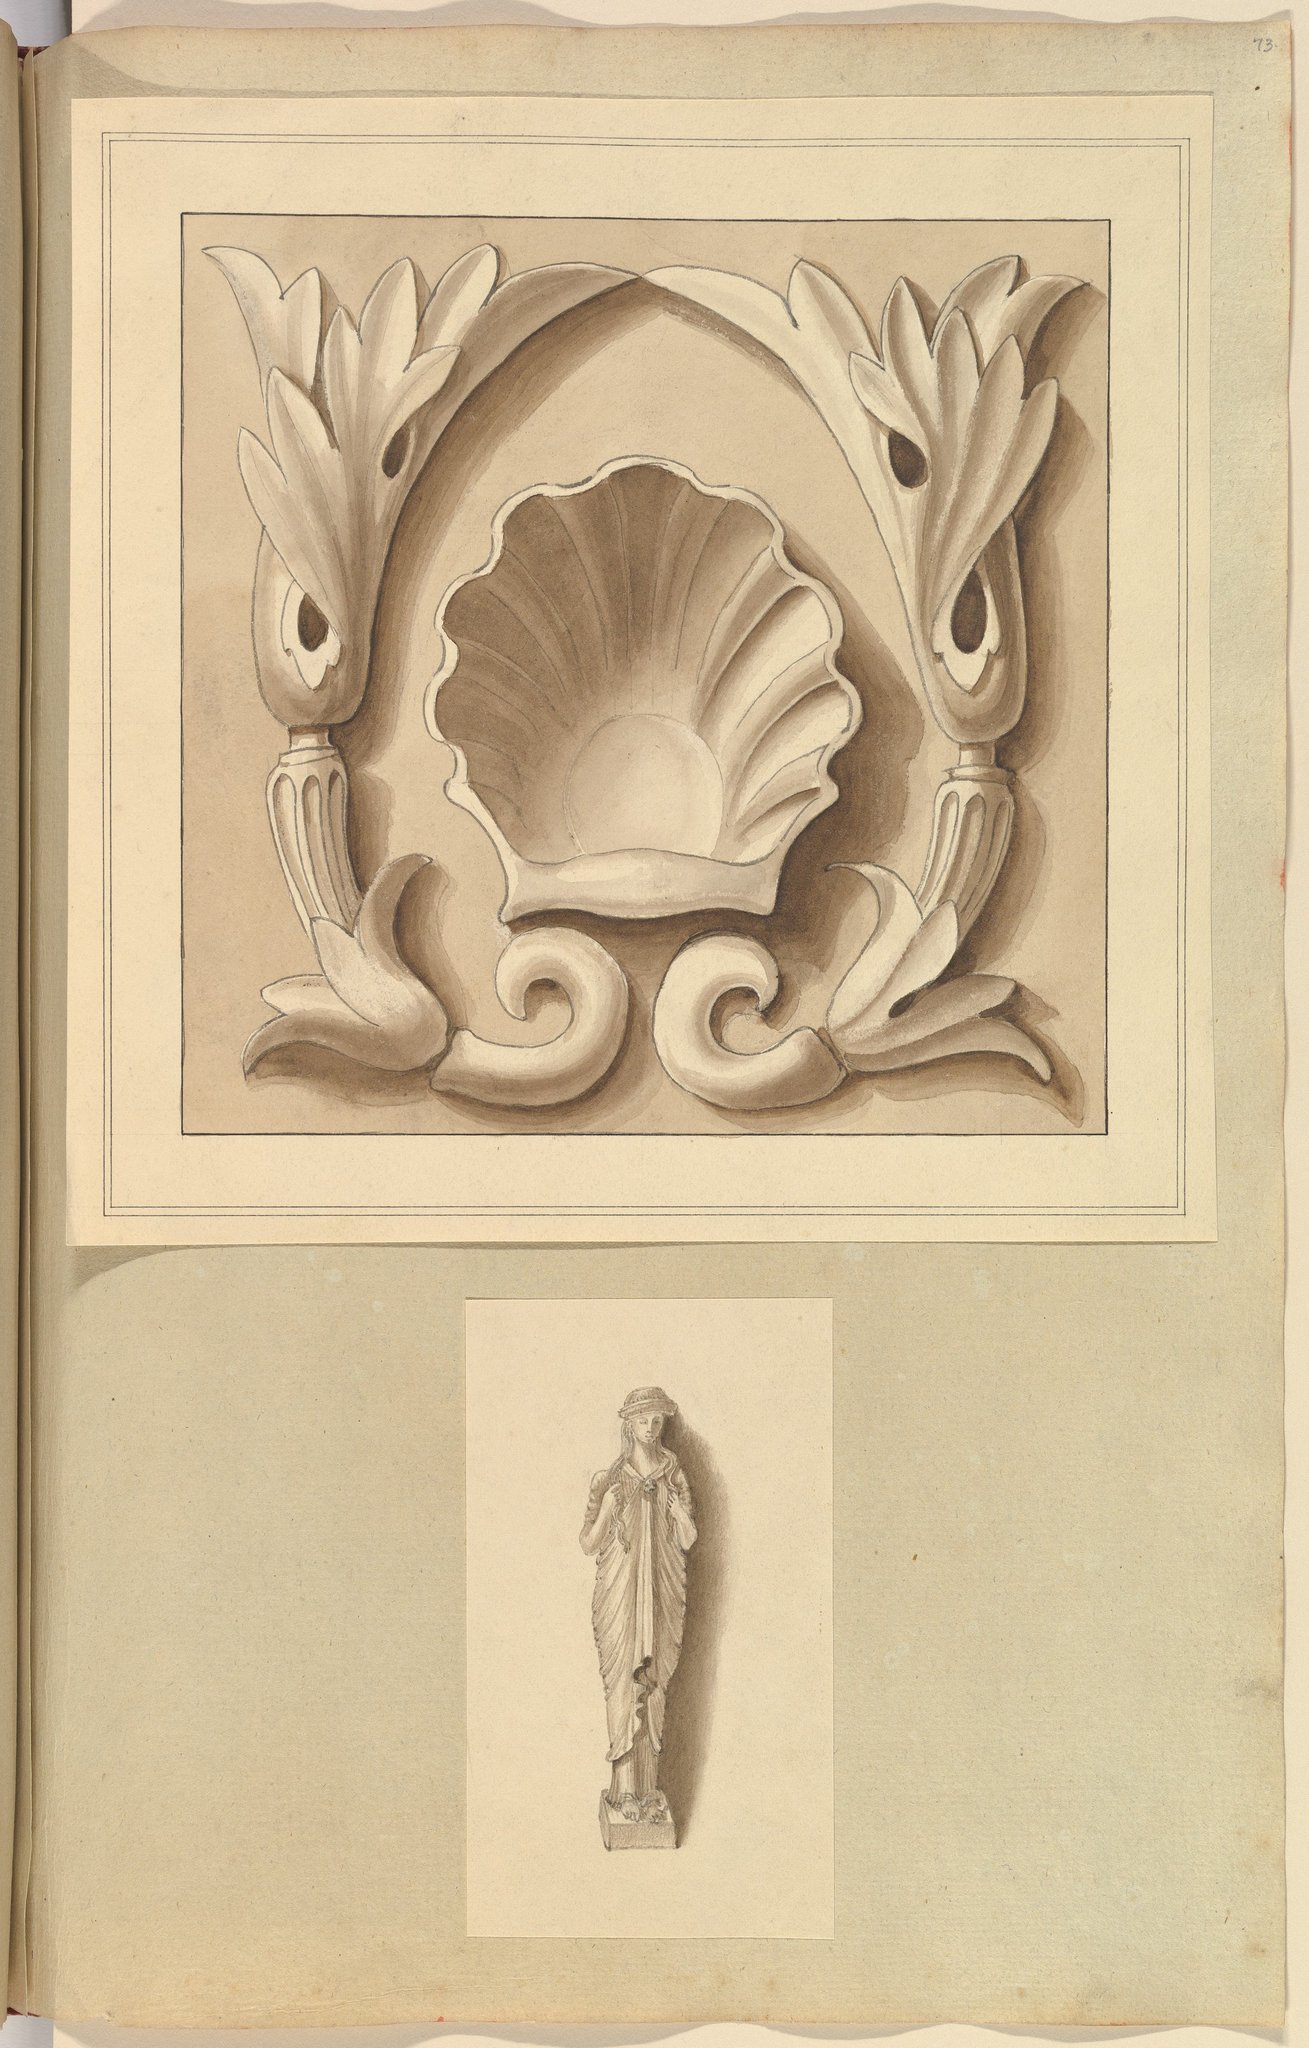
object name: drawing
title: Carved Stone Ornamental Panel and Classical Female Figure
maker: alfred henry forrester [alfred crowquill]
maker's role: artist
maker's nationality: british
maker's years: 1804-1872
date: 1845-1870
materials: ink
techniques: brush, pen, wash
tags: women,shells